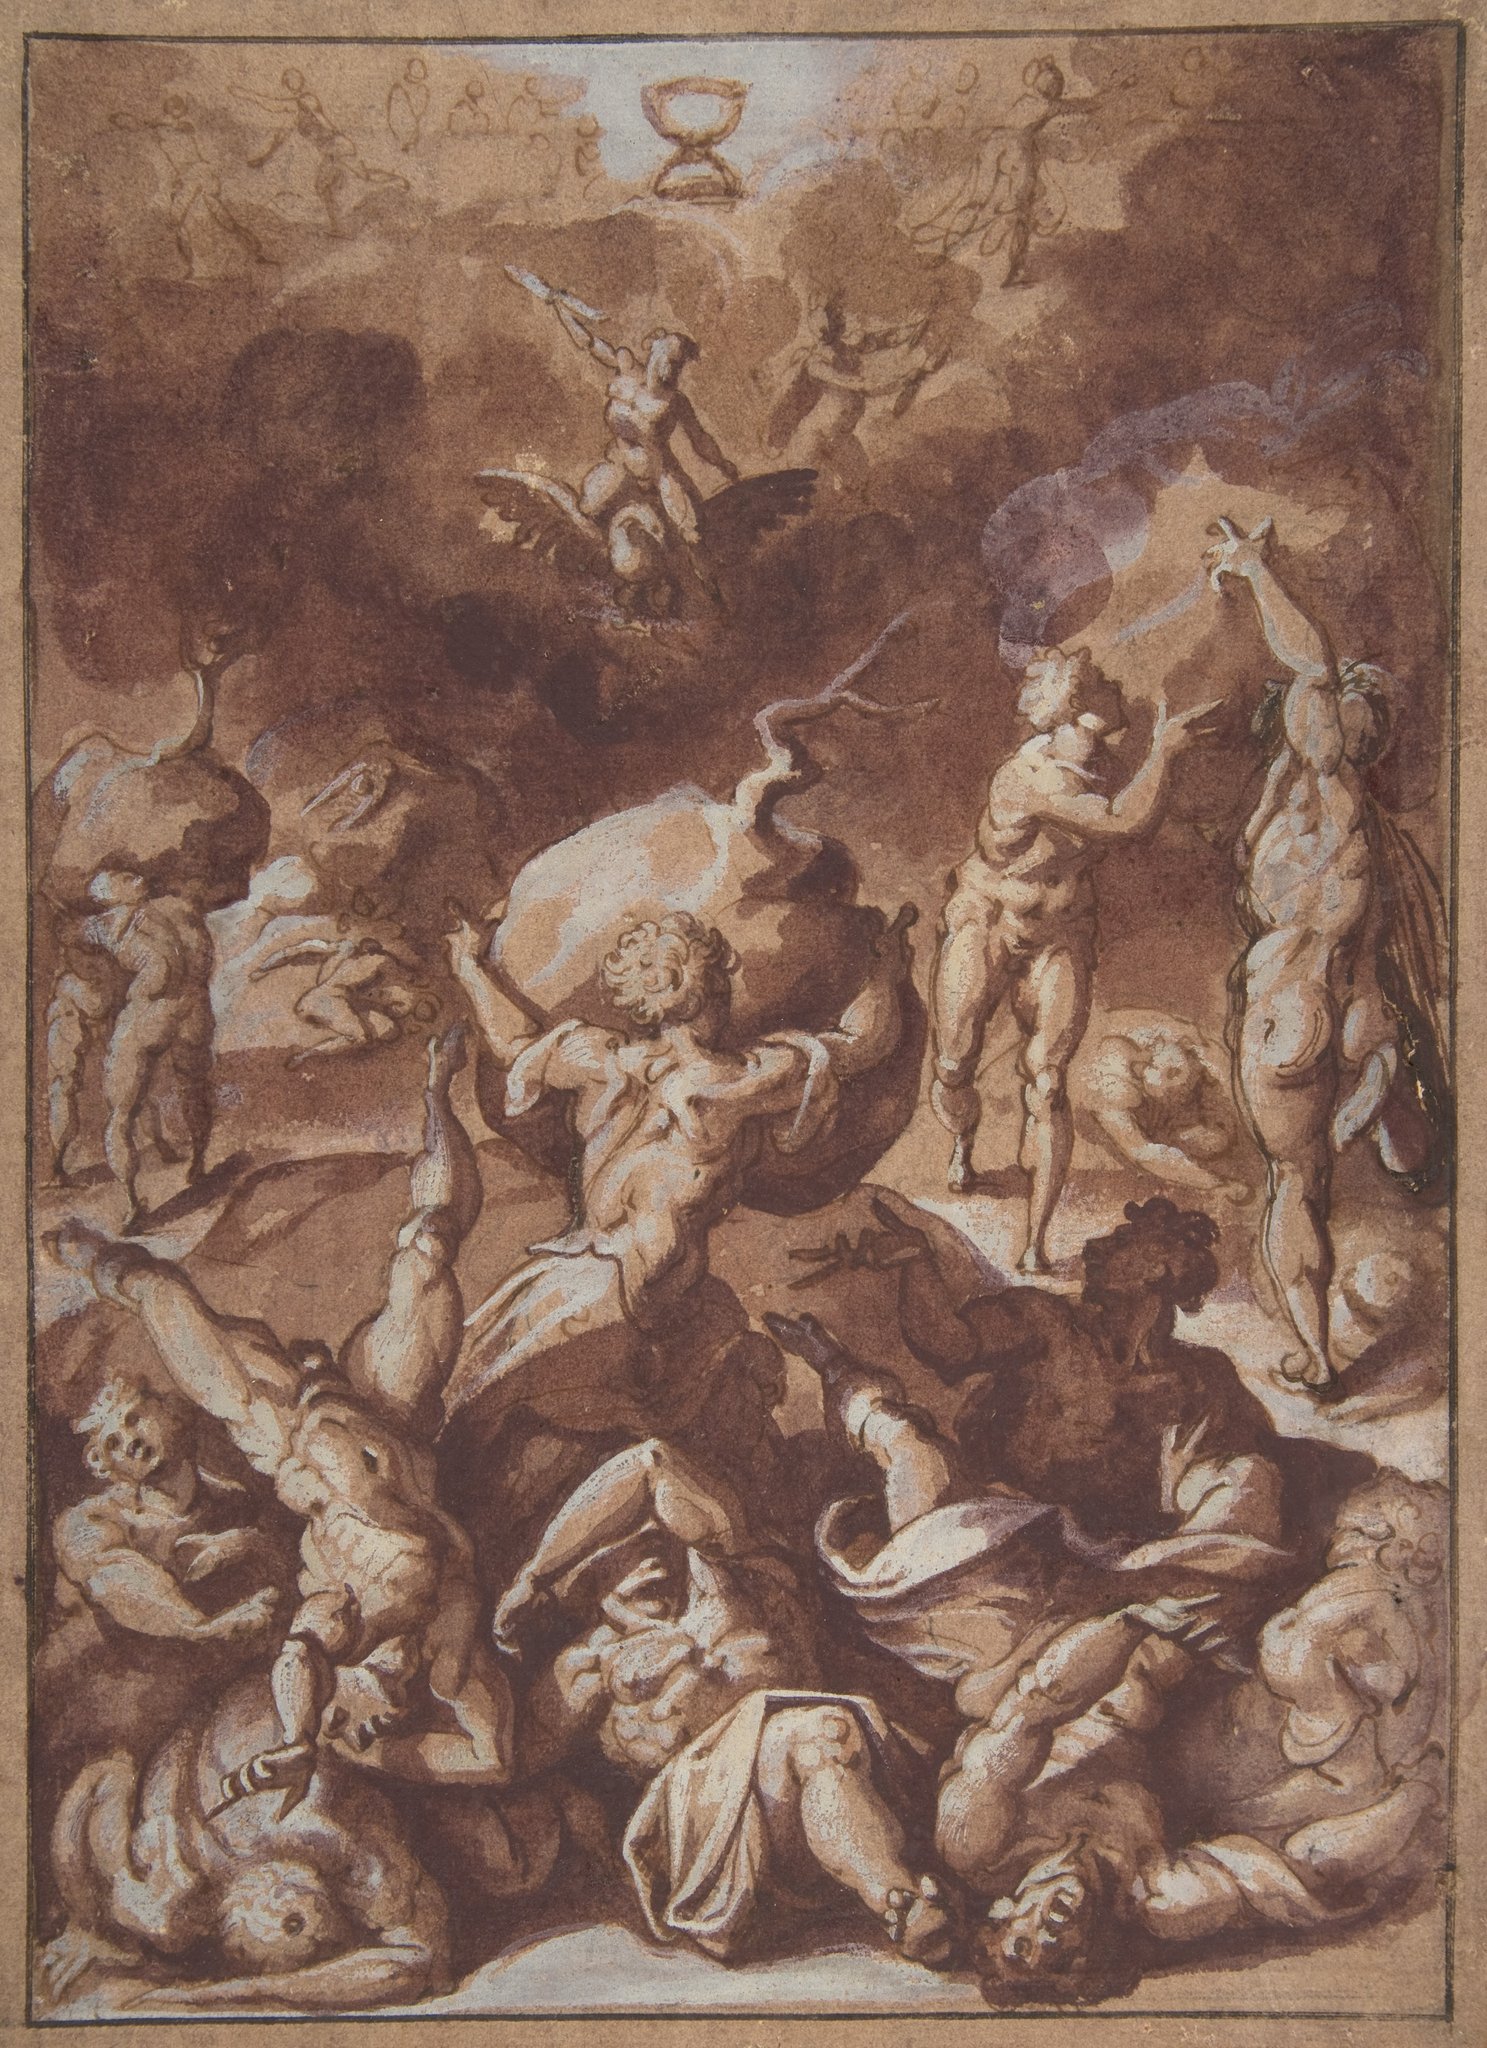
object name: drawing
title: Jupiter Fighting the Giants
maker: jacopo zucchi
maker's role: artist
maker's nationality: italian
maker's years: 1540-1596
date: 1540-1596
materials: chalk, gouache, ink, paper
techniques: brush, highlighting, pen, wash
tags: jupiter,devil